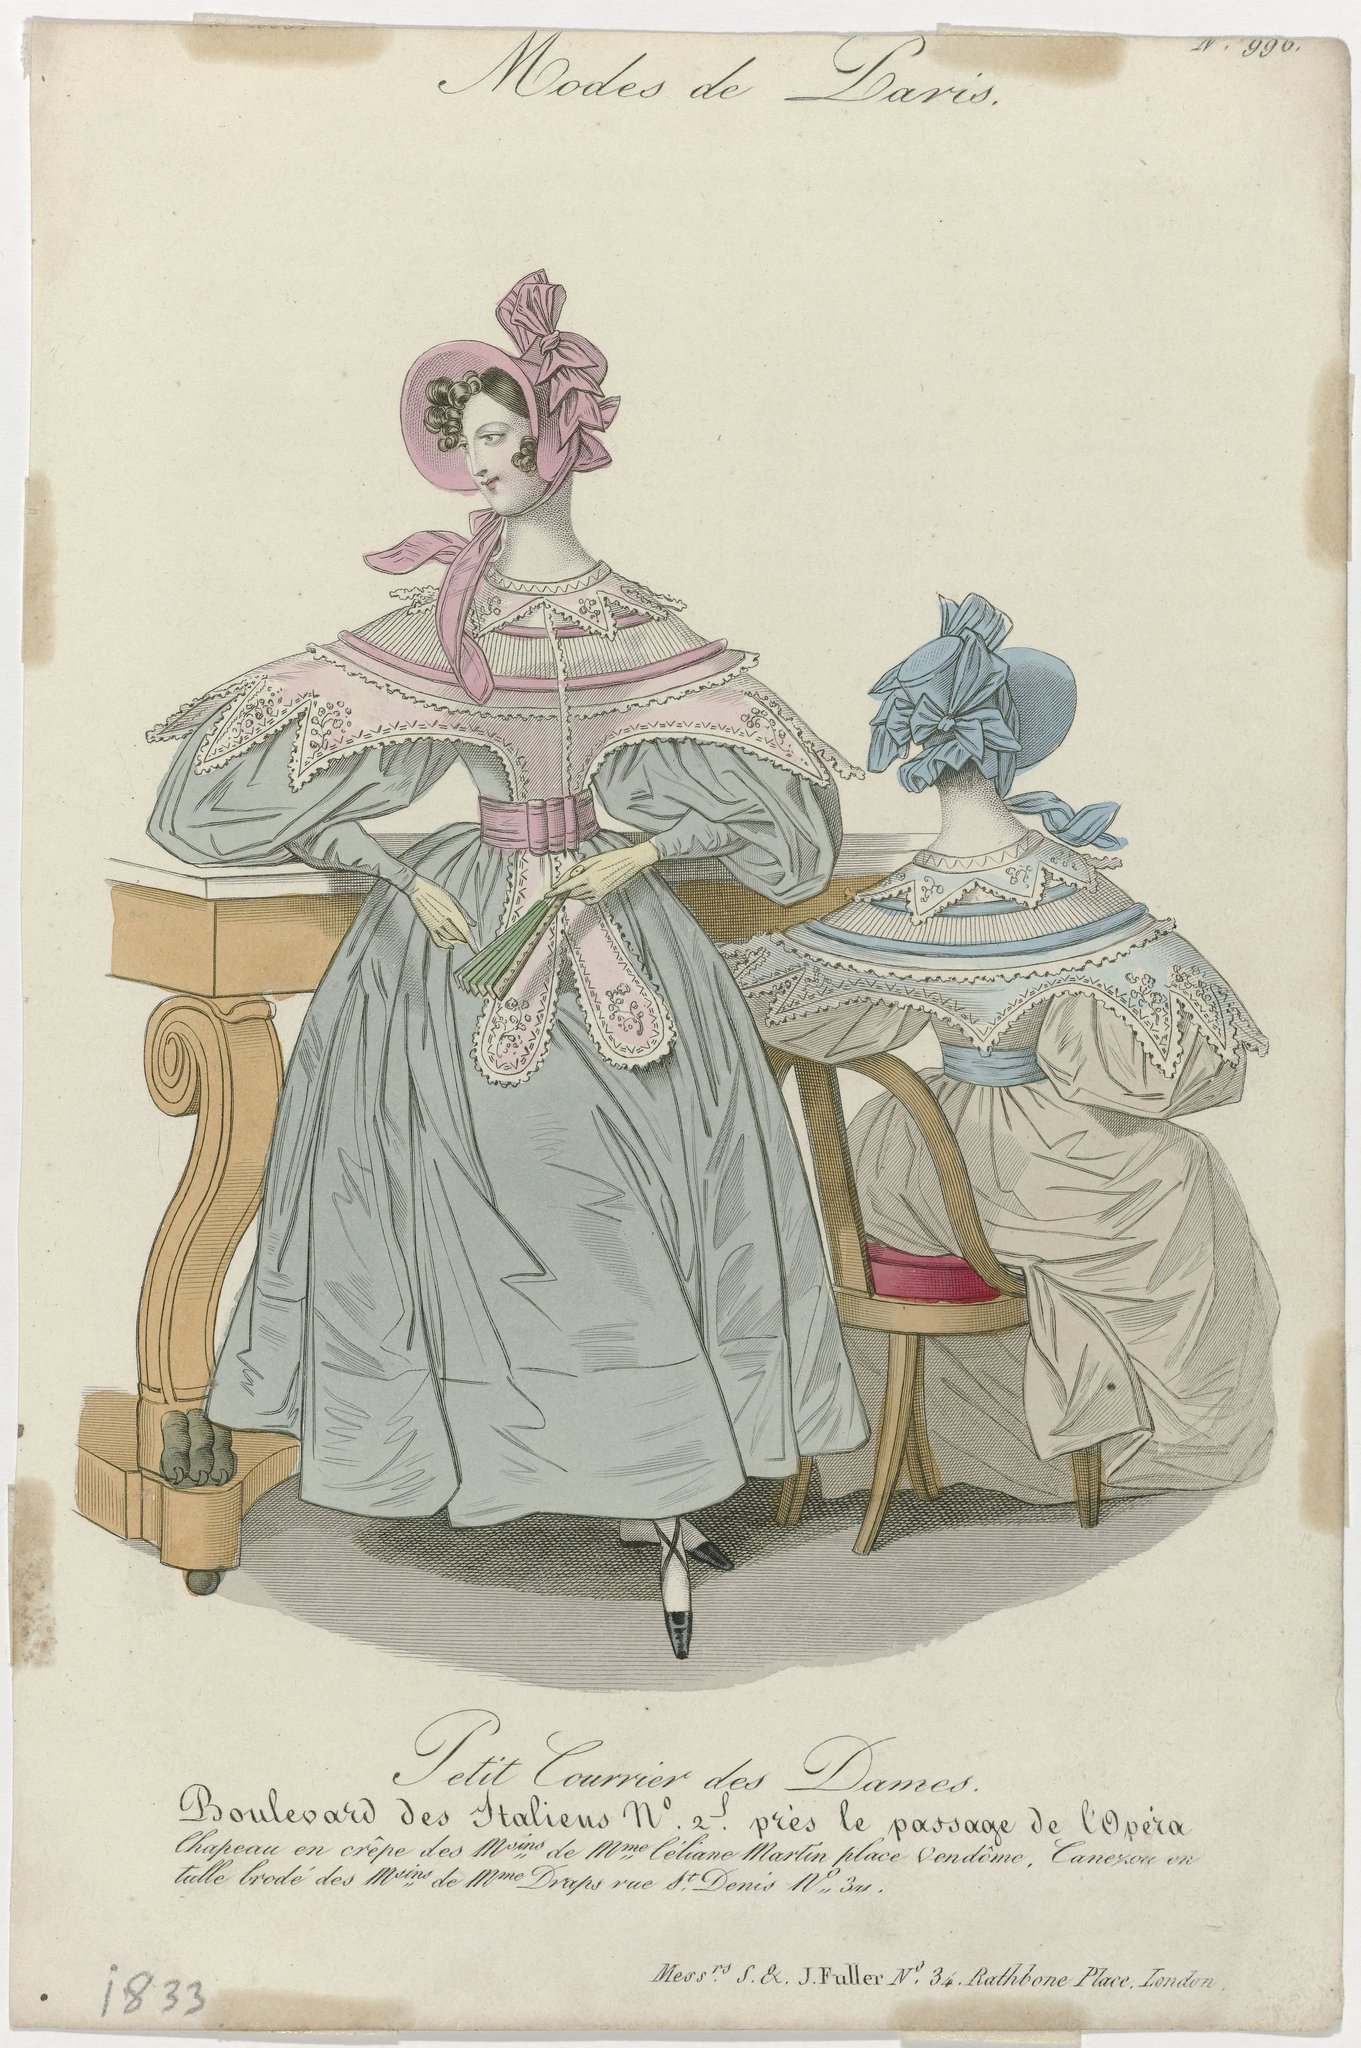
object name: fashion print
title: Petit Courrier des Dames, 1833, No. 996 : Chapeau en crêp (...)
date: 1833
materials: paper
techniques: engraving, hand coloring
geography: paris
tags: embroidery (ornamentation) (+ women's clothes), fashion plates, head-gear: hat (+ women's clothes), dress, gown (+ women's clothes), fan (+ women's clothes), belt, girdle, waistband (+ women's clothes)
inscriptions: caption: ‘Chapeau en crêpe des M"sins de M"me Céliane Martin place Vendôme, Canezou en tulle brodé des M"sins de Mme Draps rue St. Denis No"311.’, address: ‘Boulevard des Italiens No.2 près le passage de l'Opèra. / Mess.rs S.&.J. Fuller No.34. Rathbone Place. London’, title: ‘Modes de Paris.’, title: ‘Petit Courrier des Dames.’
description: Hoed van crêpe uit de winkels van Céliane Martin. 'Canezou' van geborduurde tule uit de winkels van Mme Draps. Japon. Verdere accessoires: ceintuur, handschoenen, waaier, platte schoenen met gekruiste banden en vierkante neuzen. Prent uit het modetijdschrift Petit Courrier des Dames (1821-1868).